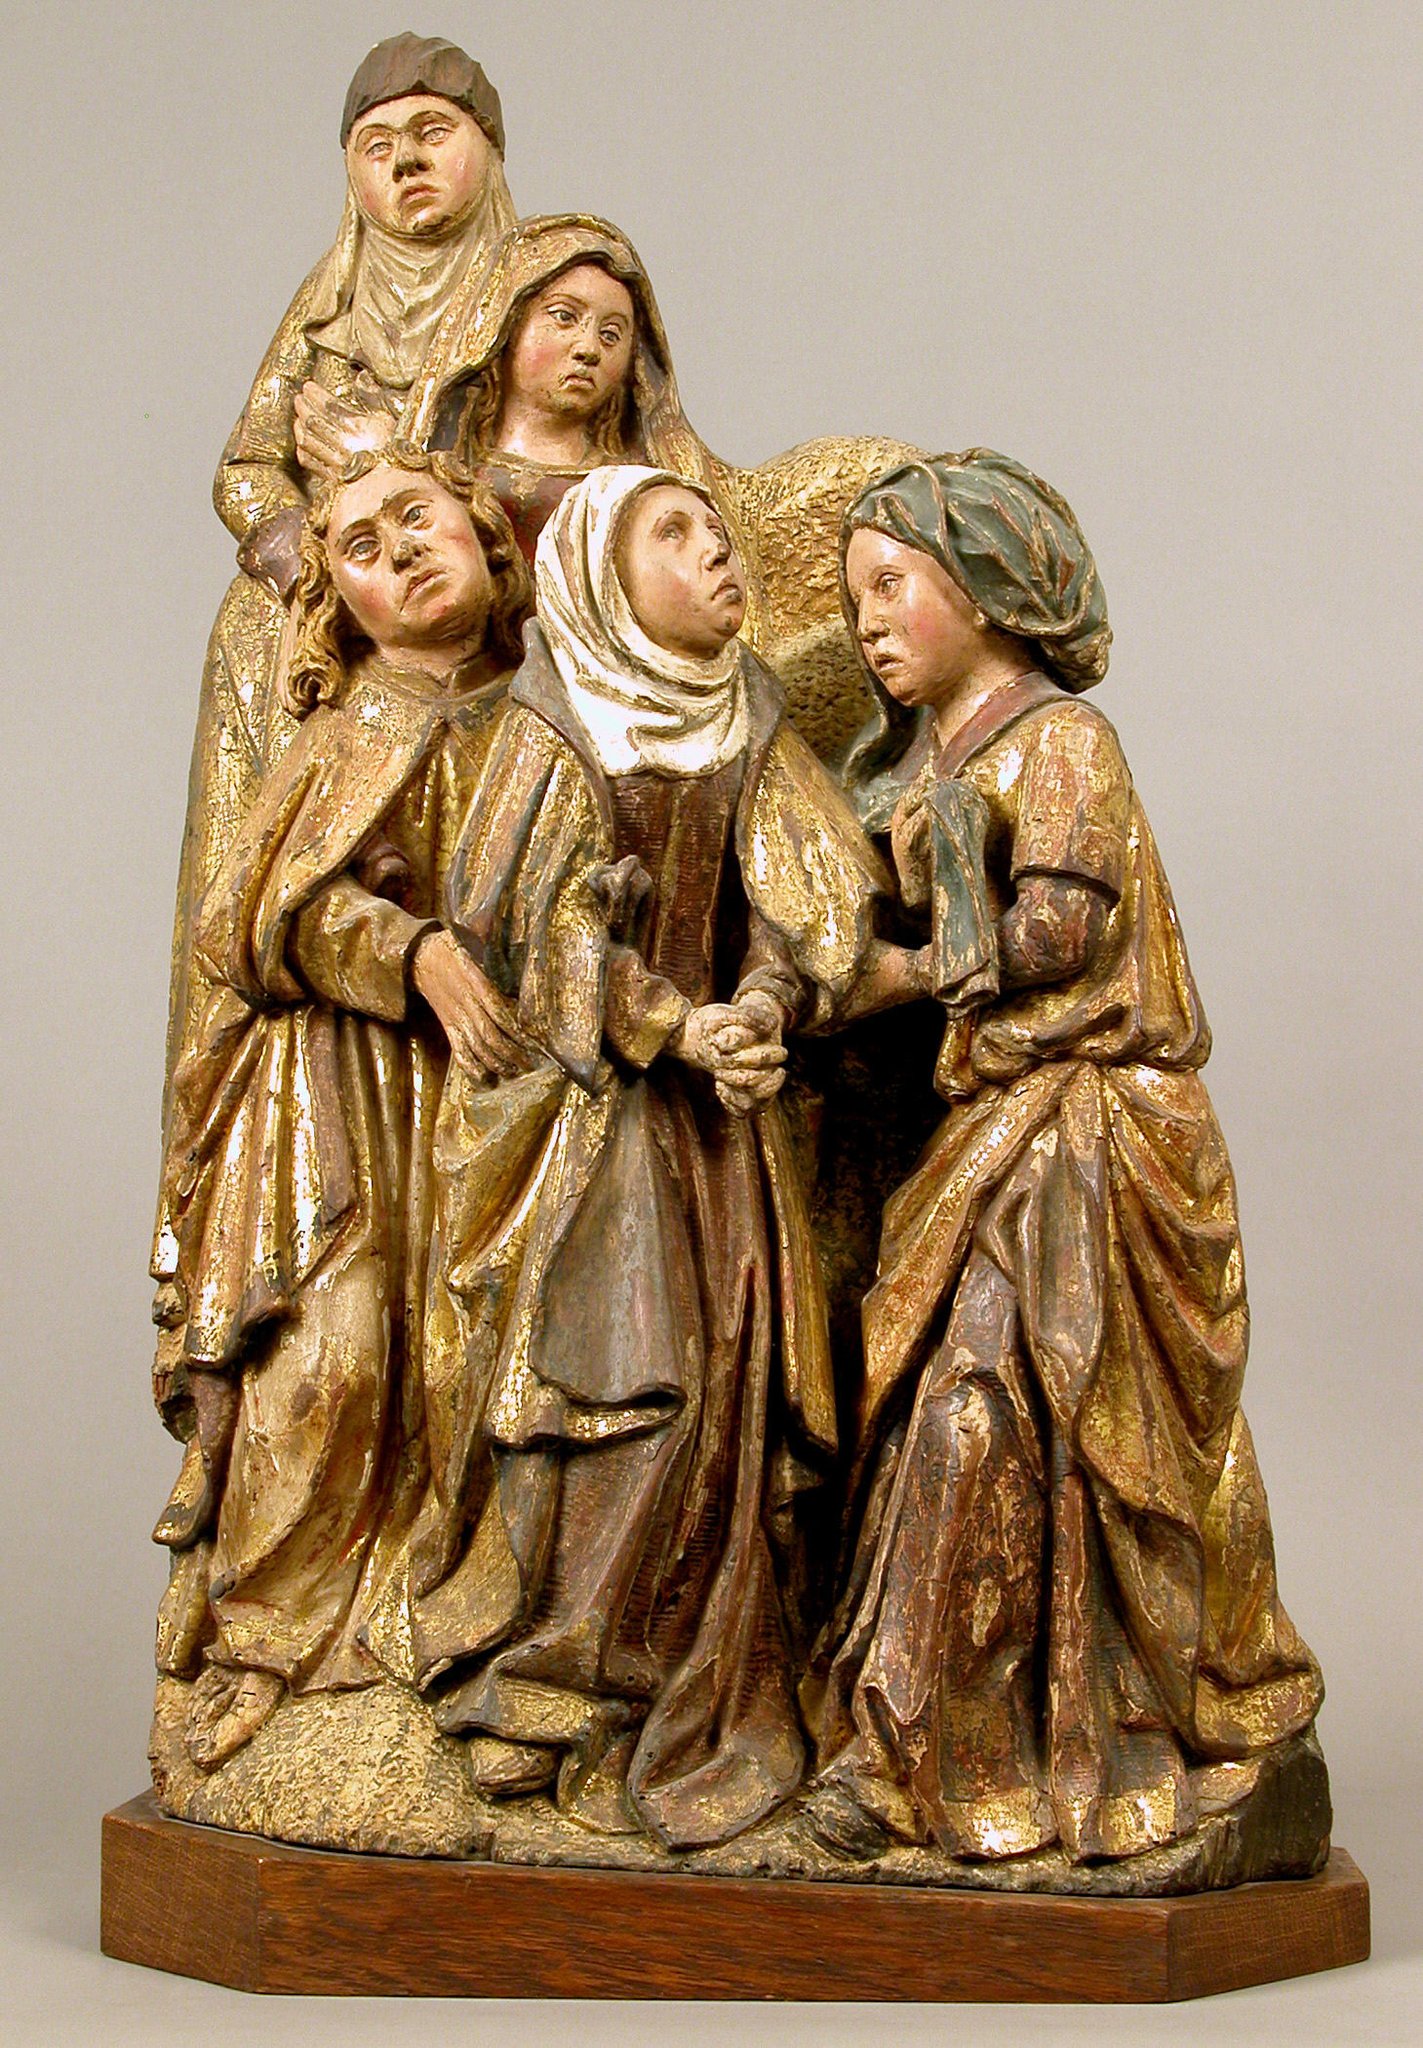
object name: relief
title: Virgin, Saint John, and Three Holy Women from a Crucifixion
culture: south netherlandish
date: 1467-1500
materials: wood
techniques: gilding, polychromy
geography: brussels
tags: saint john the baptist,virgin mary